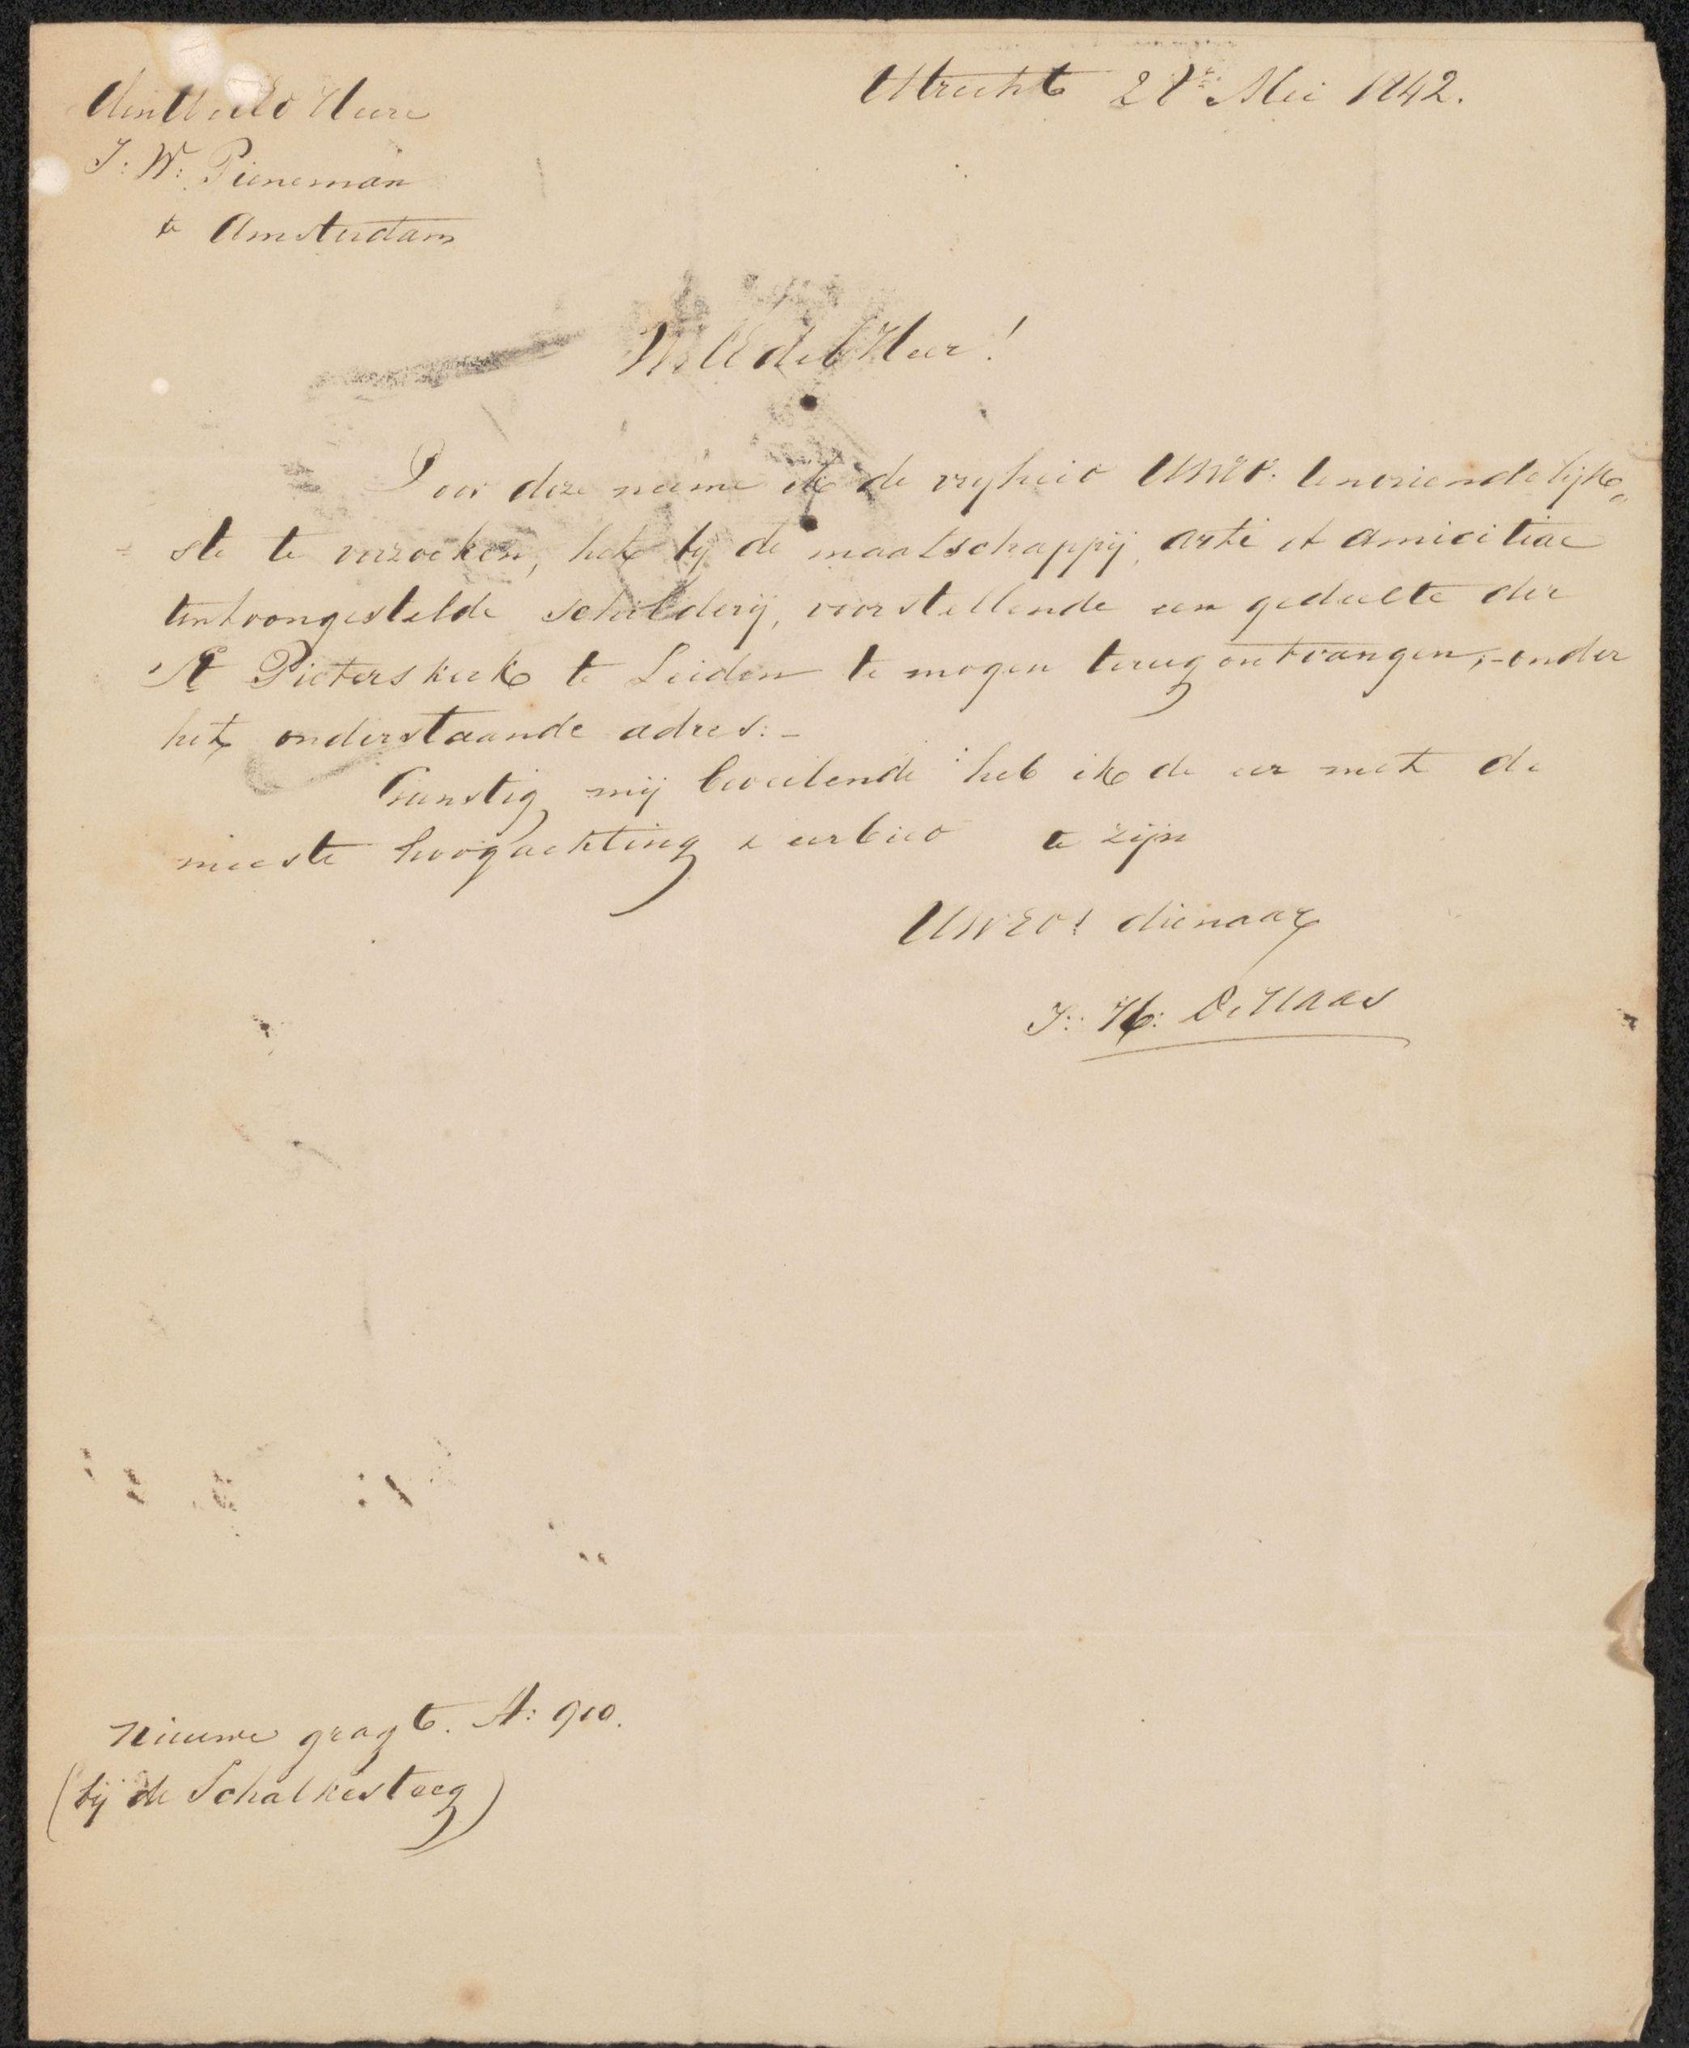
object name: letter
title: Brief aan Jan Willem Pieneman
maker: jan herman de haas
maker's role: conservator, painter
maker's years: 1810-1856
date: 1842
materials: ink, paper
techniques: pen, writing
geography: utrecht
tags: abcoude, amsterdam, painter, print maker, draughtsman, jan willem pieneman, painting (including book-illumination, miniature-painting), exhibition ~ art